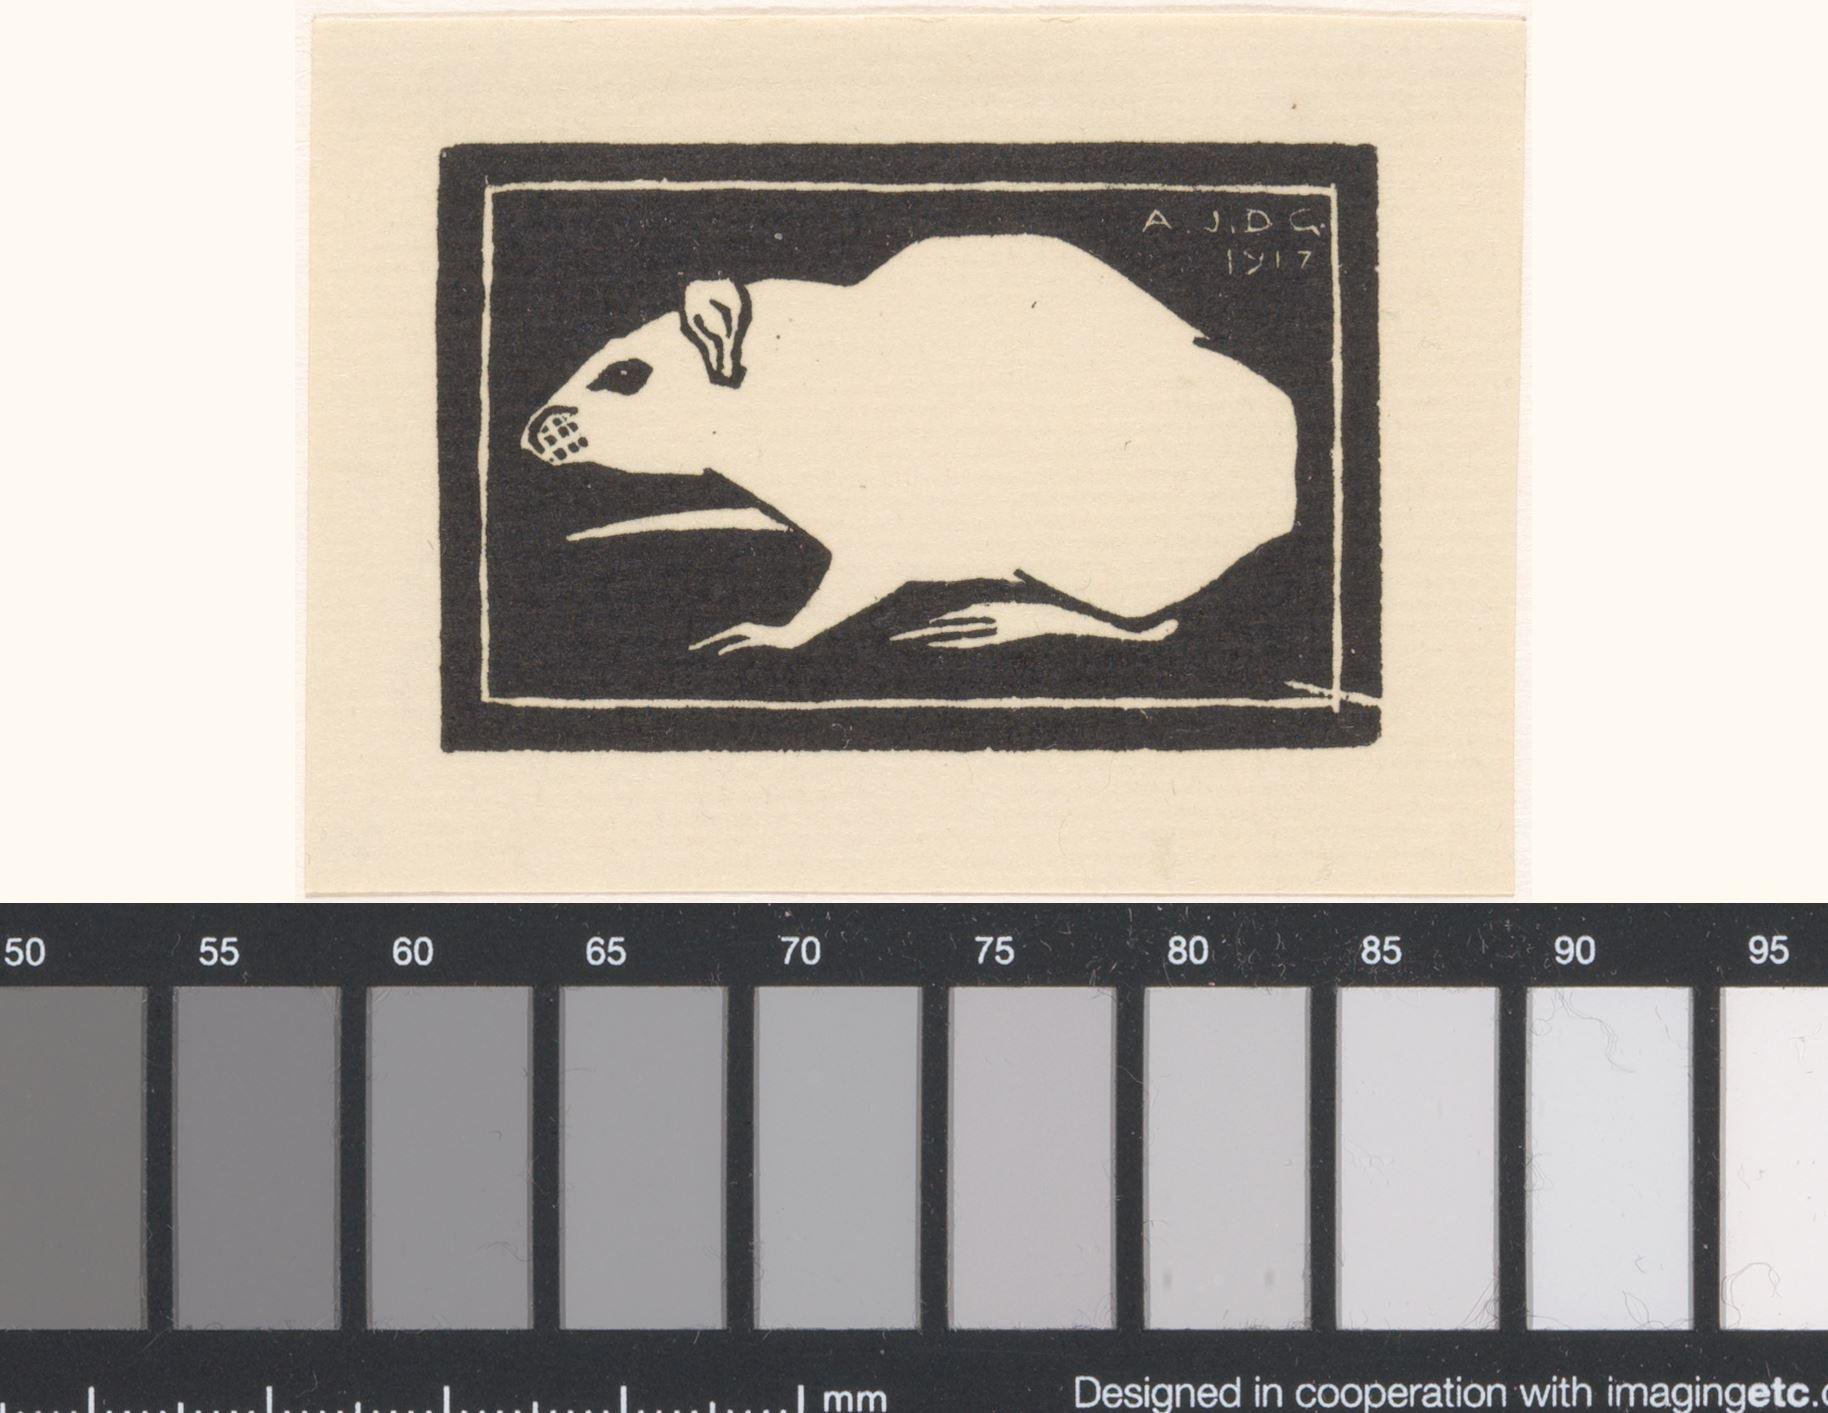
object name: print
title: Muis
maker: julie de graag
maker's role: draughtsman, print maker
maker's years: 1877-1924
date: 1917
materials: paper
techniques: woodcut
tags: rodents: mouse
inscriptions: collector's mark: Lugt 2228